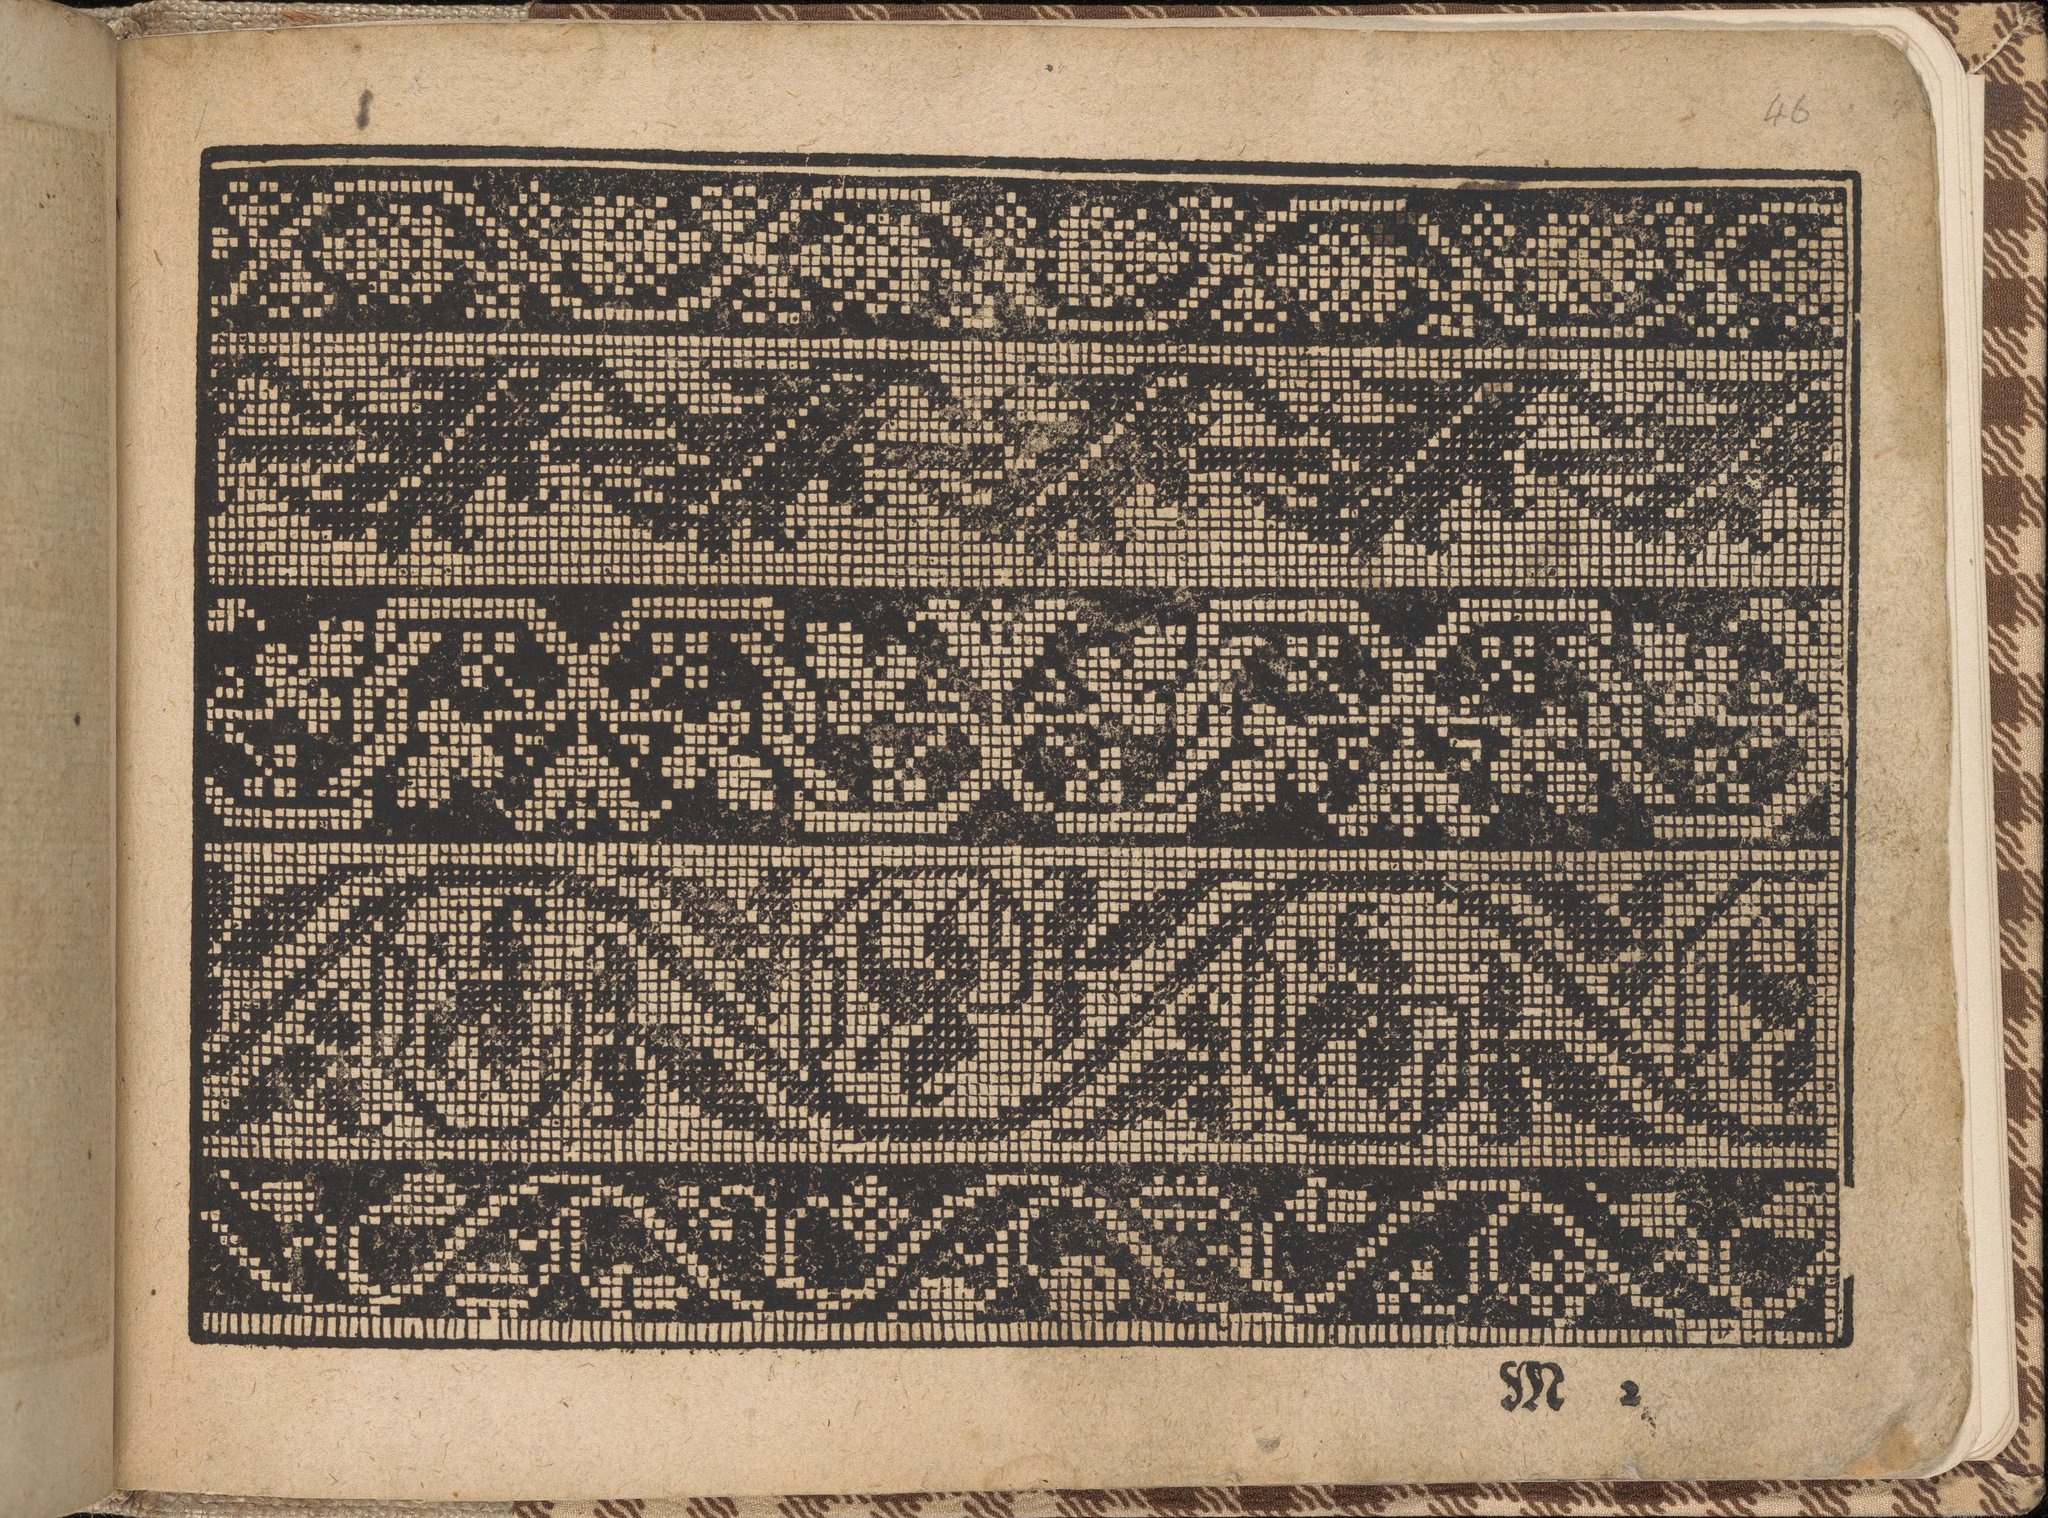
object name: book print ornament architecture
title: New Künstlichs Modelbuch (Page 46 recto)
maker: bernhard jobin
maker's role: publisher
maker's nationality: swiss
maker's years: 1535-1597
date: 1600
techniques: woodcut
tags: ornament